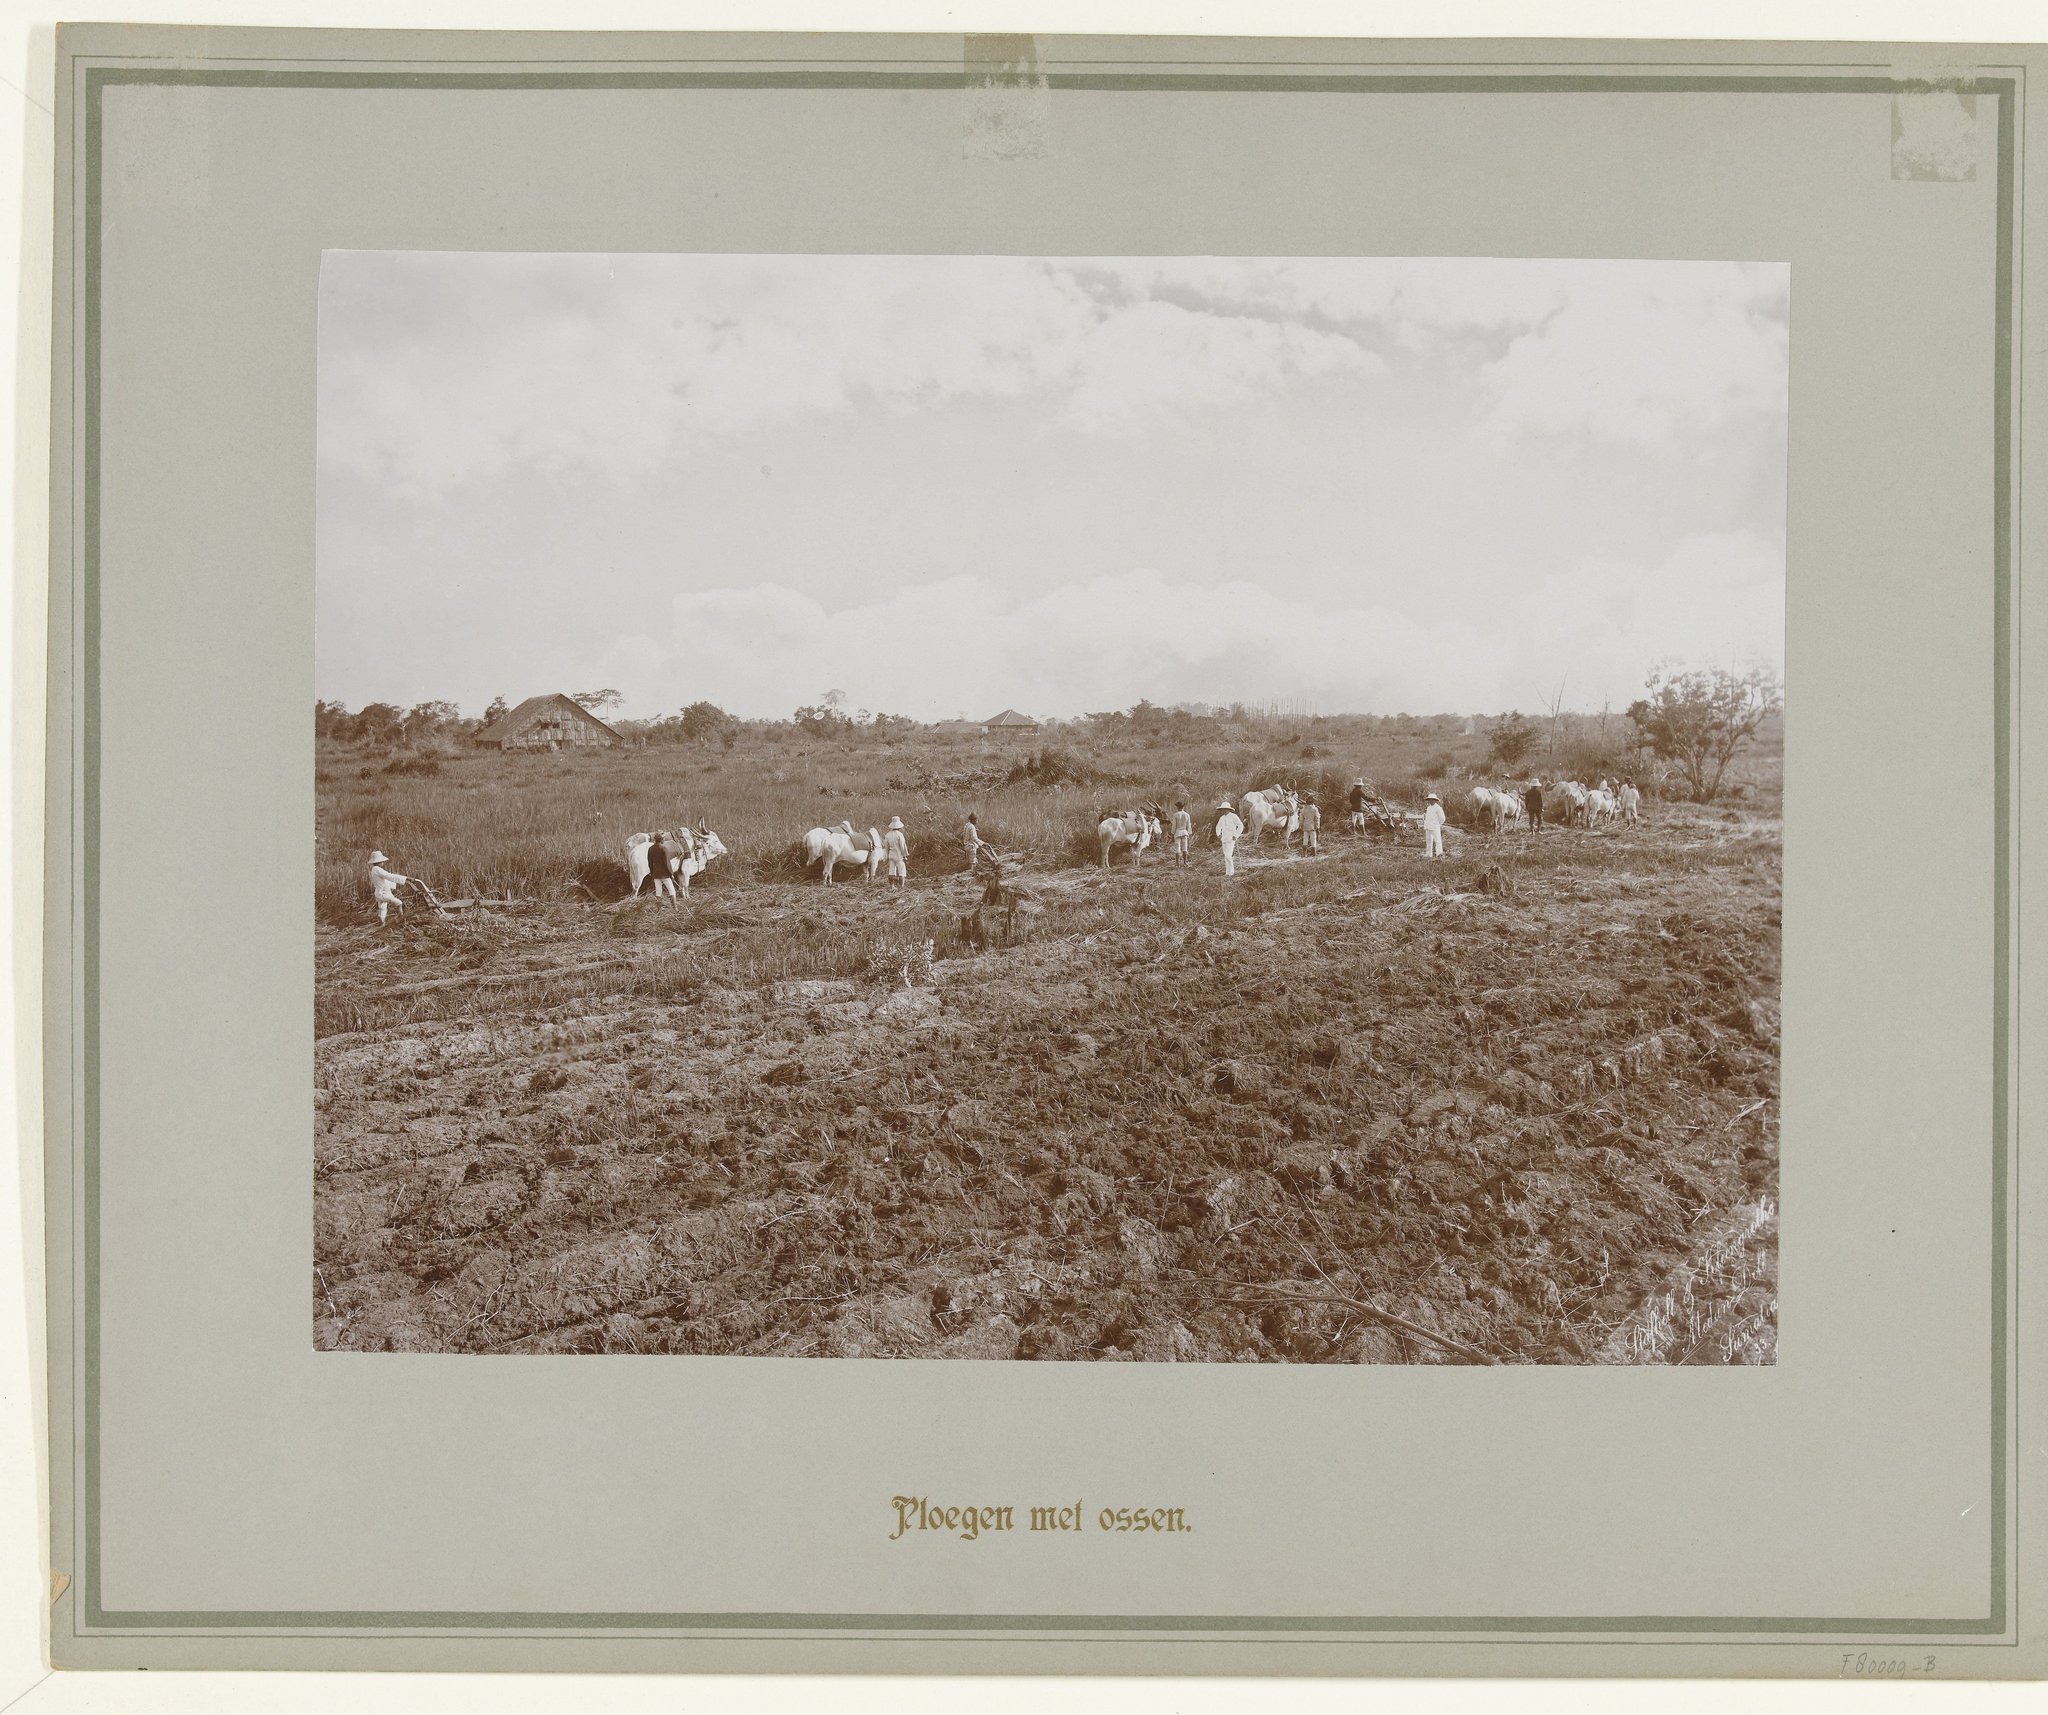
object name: photograph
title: Ploegen met ossen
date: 1890-1900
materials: cardboard, paper, photographic support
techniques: collodion silver print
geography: medan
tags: ploughing, sumatra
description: Arbeiders ploegen met ossen een akker op Sumatra. Foto geplakt op losgesneden blad uit album, op verso bevindt zich nog een foto uit dezelfde serie.